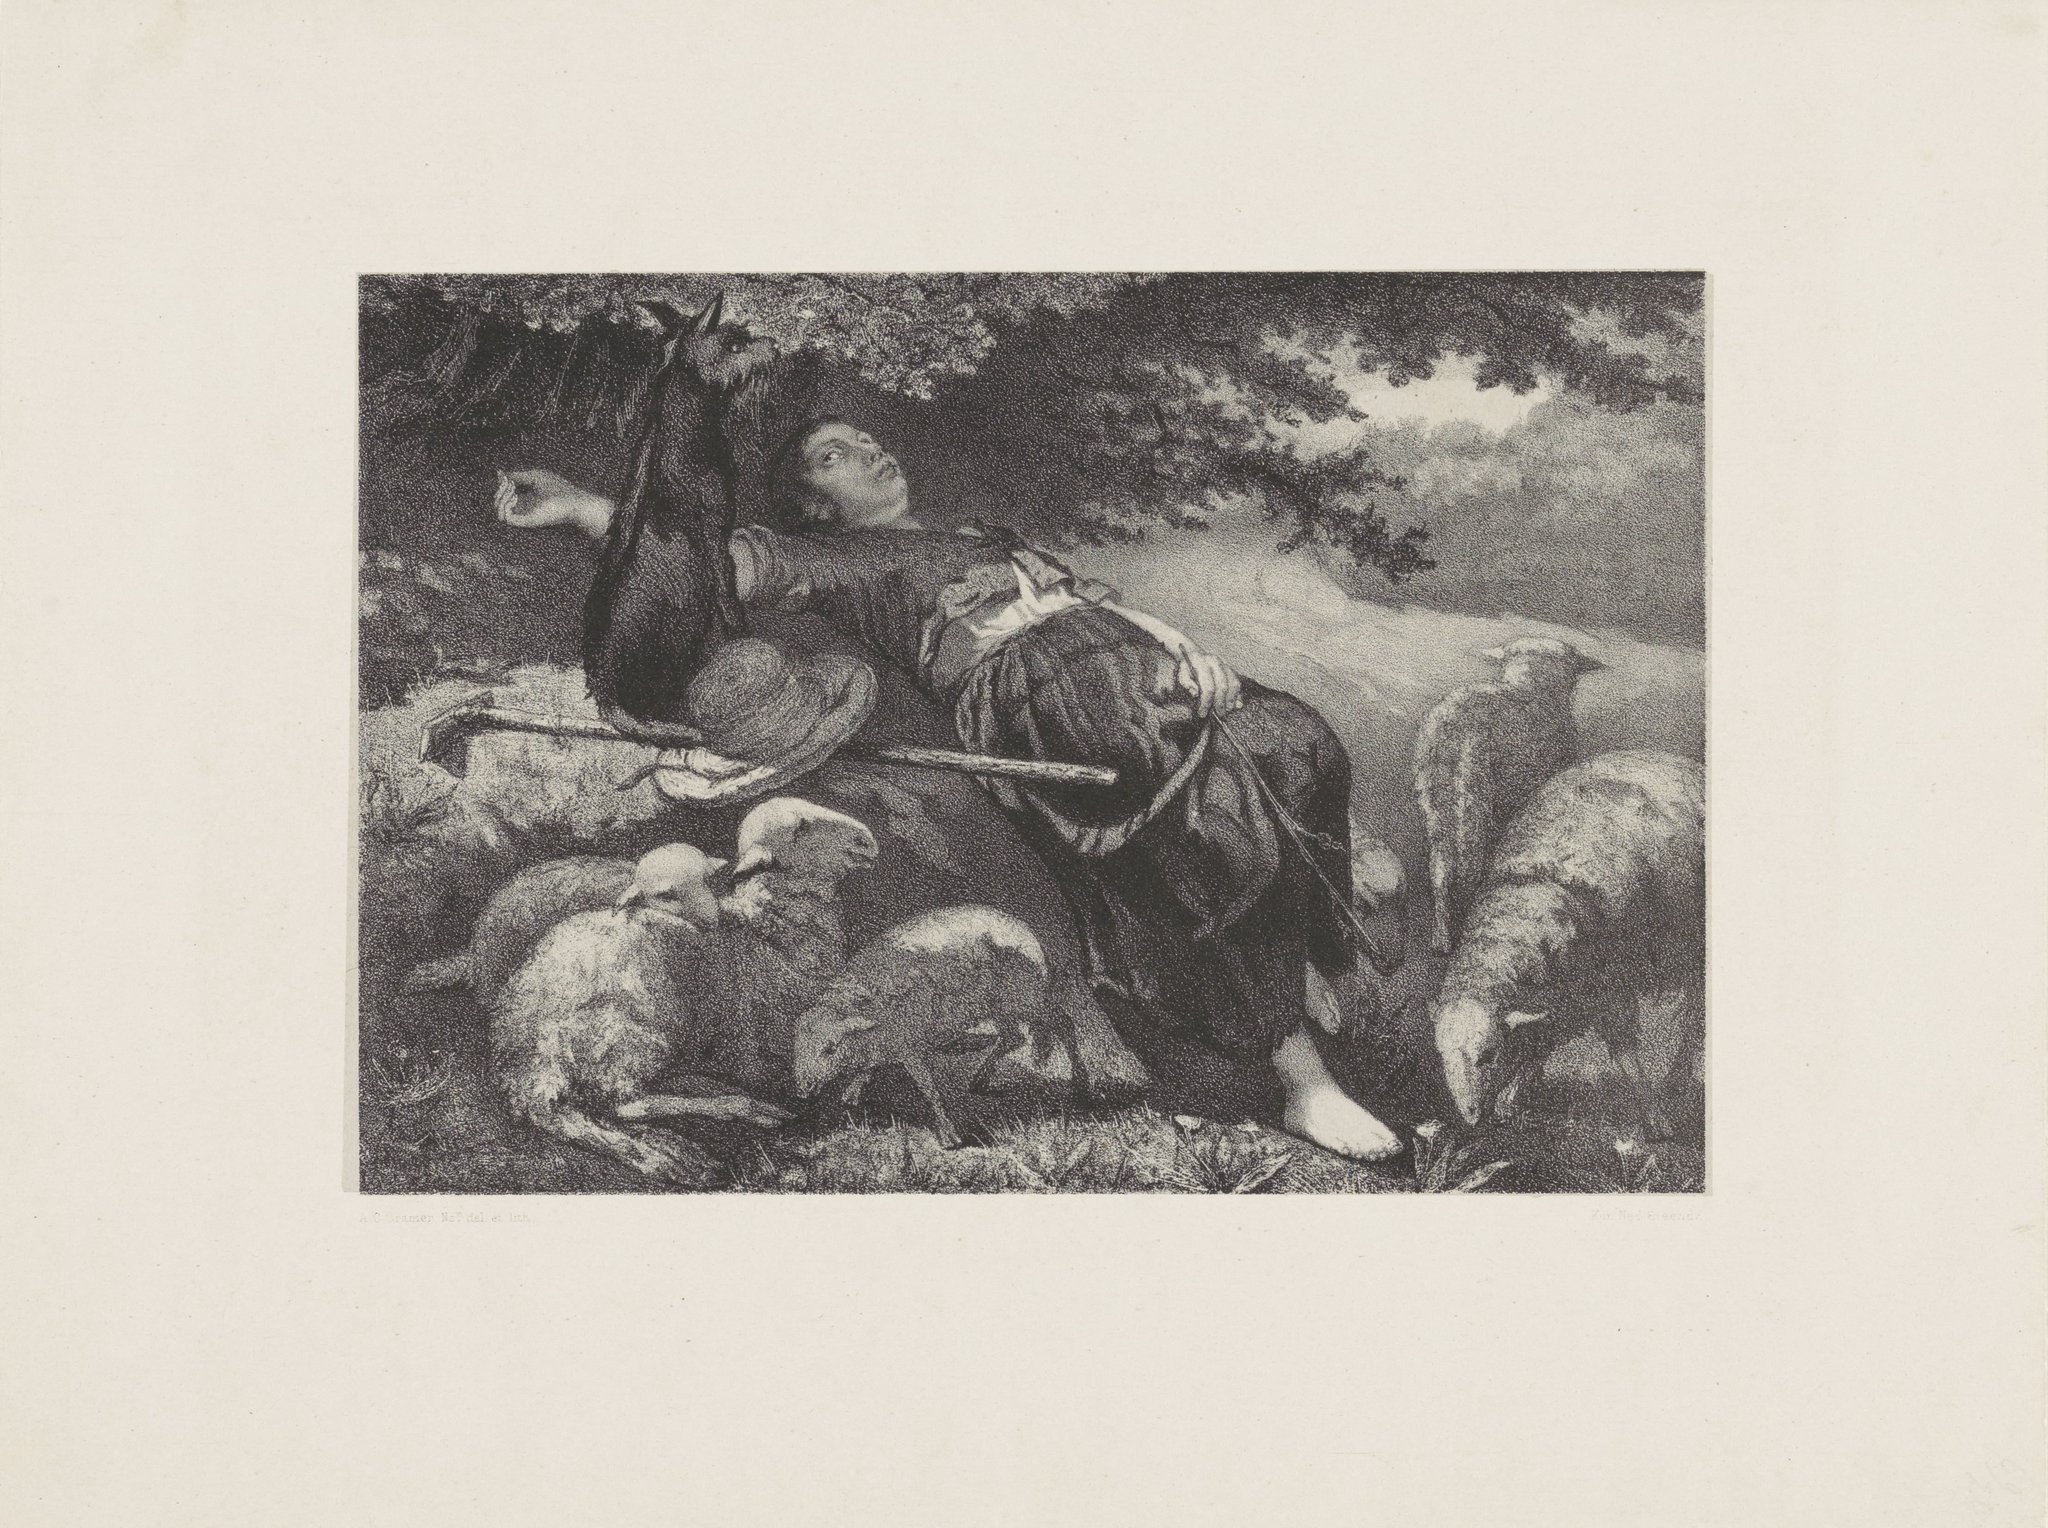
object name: print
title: Liggende herderin omgeven door schapen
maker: anthony cornelis cramer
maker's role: draughtsman, painter, print maker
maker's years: 1842-1914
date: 1867-1874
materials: paper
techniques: tone lithography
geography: amsterdam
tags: herding, herdsman, herdswoman, shepherd, shepherdess, cowherd, etc., watch-dog, dog watching, lying figure, pastorals, arcadian scenes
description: De herderin ligt op de grond onder een boom met haar rechterarm uitgestrekt. Haar staf en hoed liggen naast haar en zij kijkt naar haar hond.